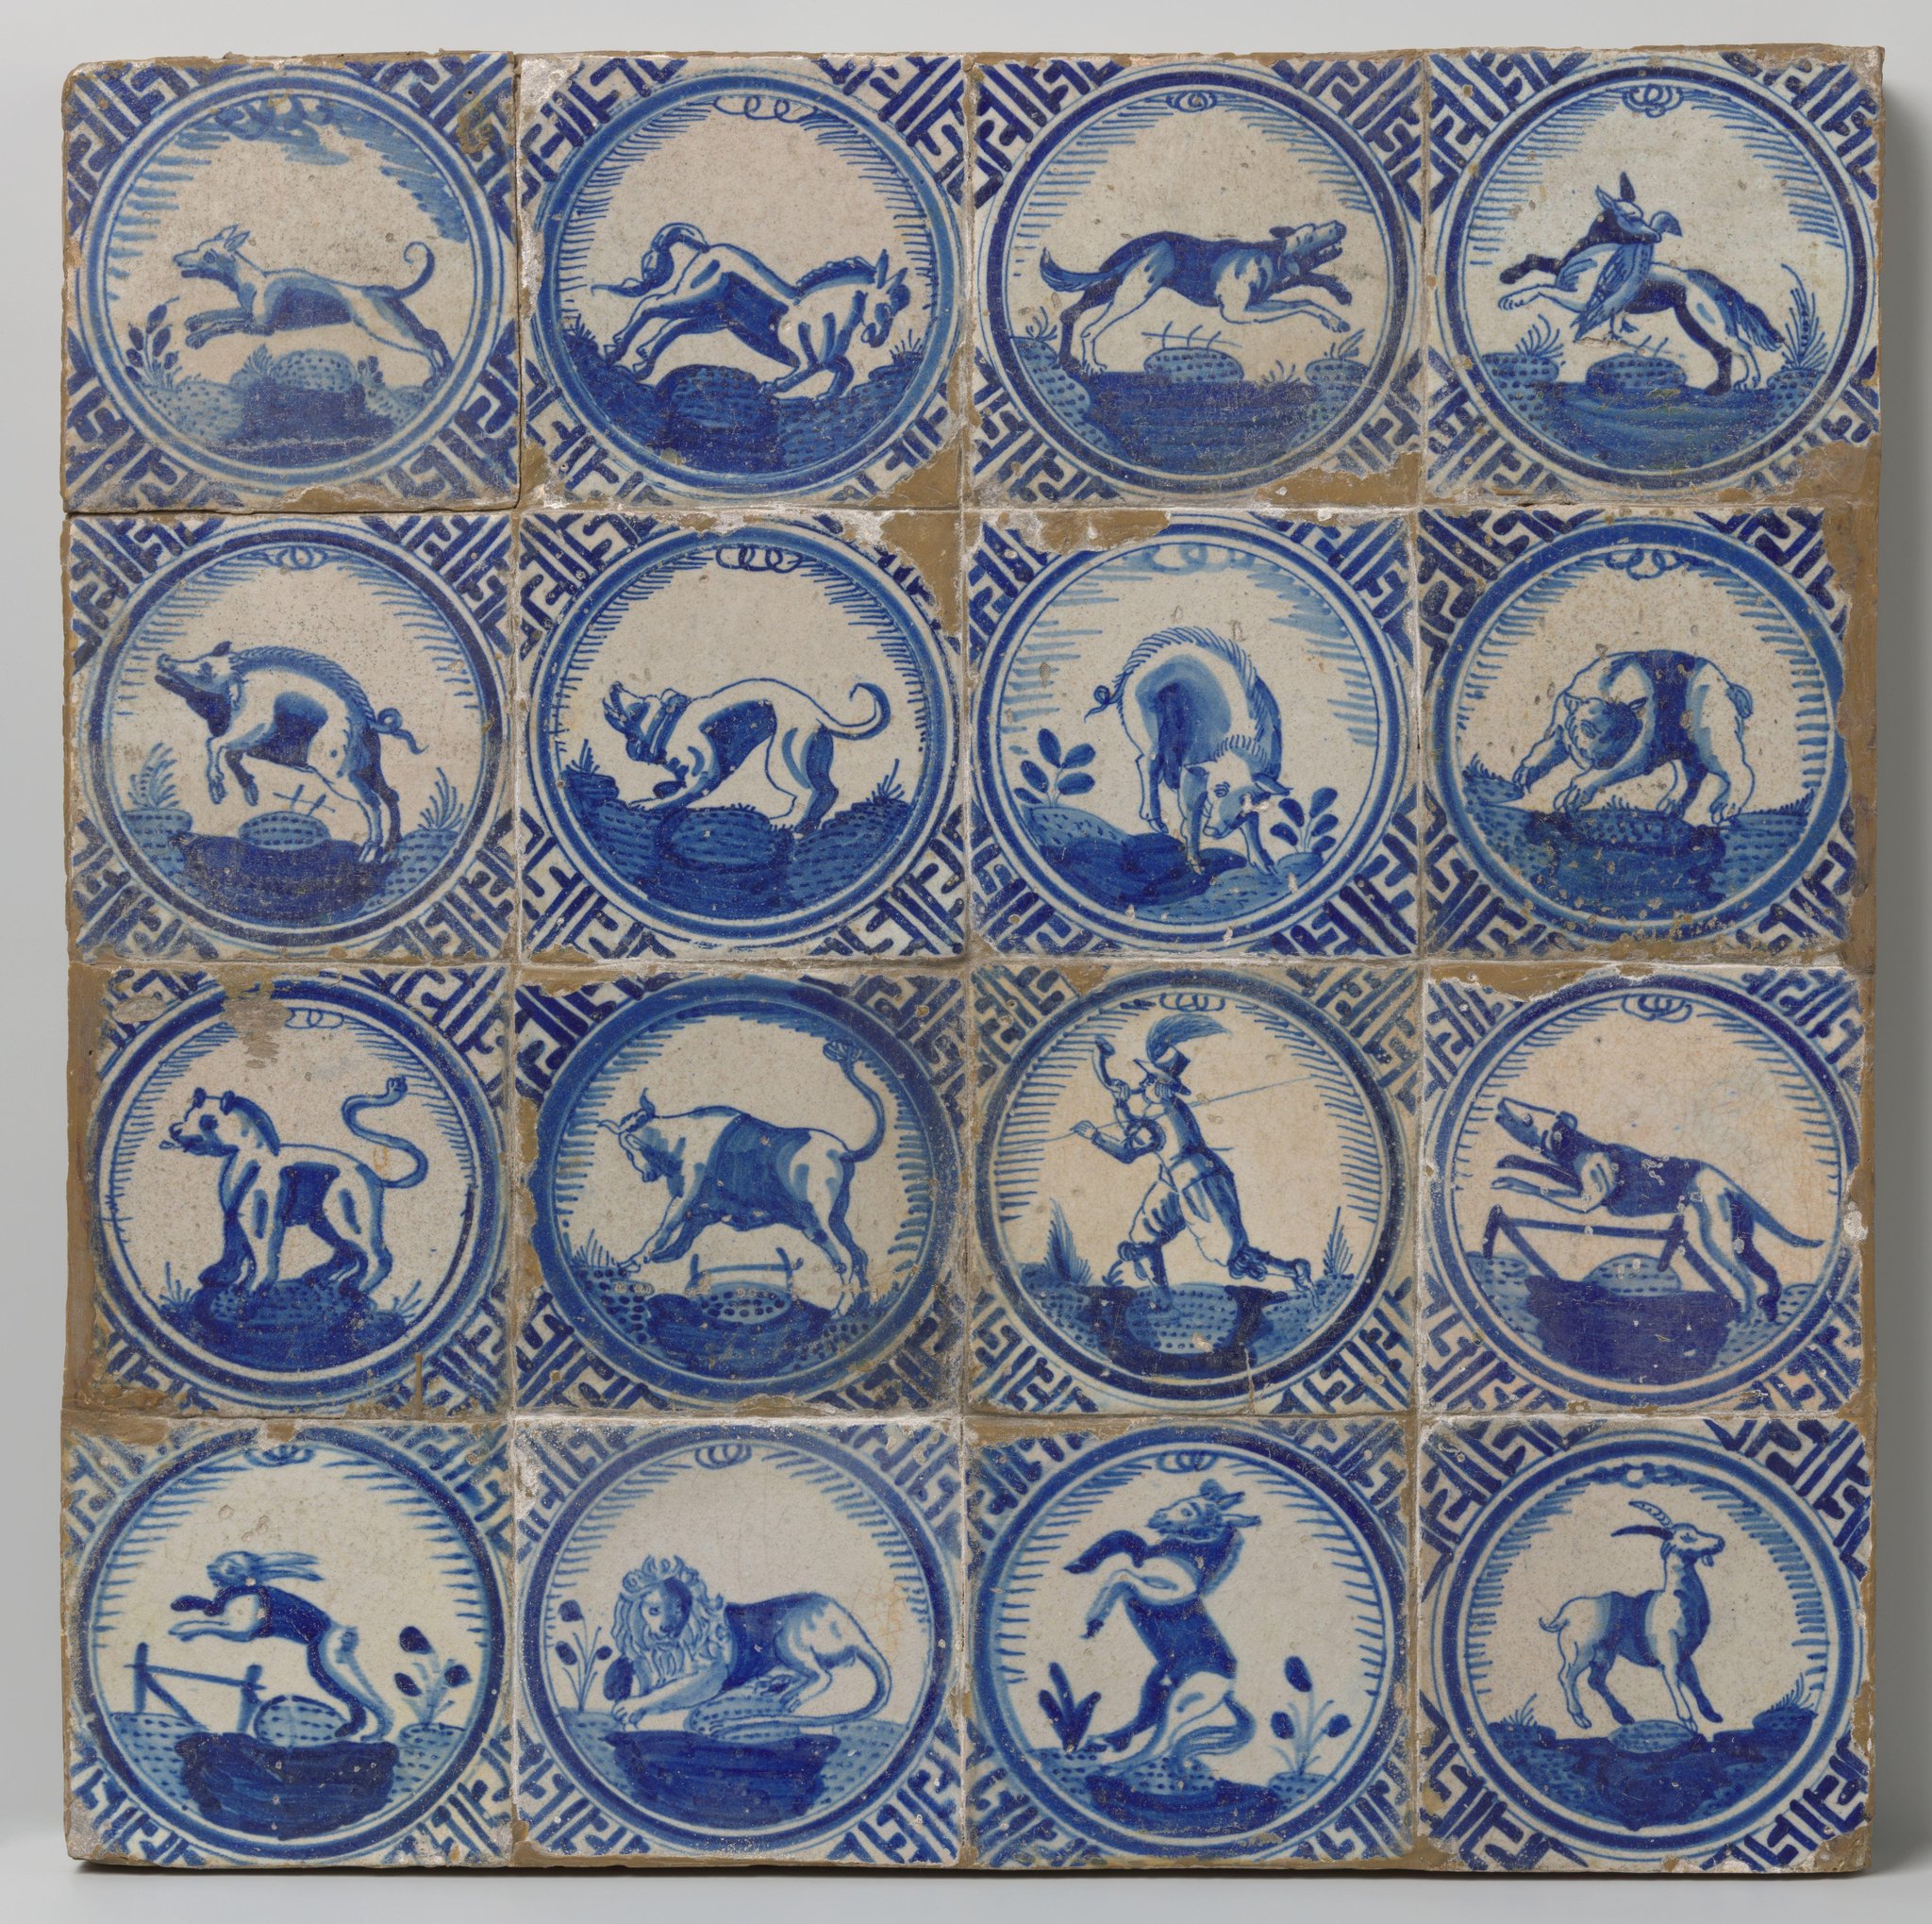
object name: tile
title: Veld van zestien tegels met dieren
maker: Anonymous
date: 1620-1640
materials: earthenware, glaze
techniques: maiolica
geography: netherlands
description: Veld van zestien tegels (4 x 4) elk met een blauw geschilderd dier op een grond (waarvan één met een jager) binnen een cirkel. In de hoeken, meander ornament.